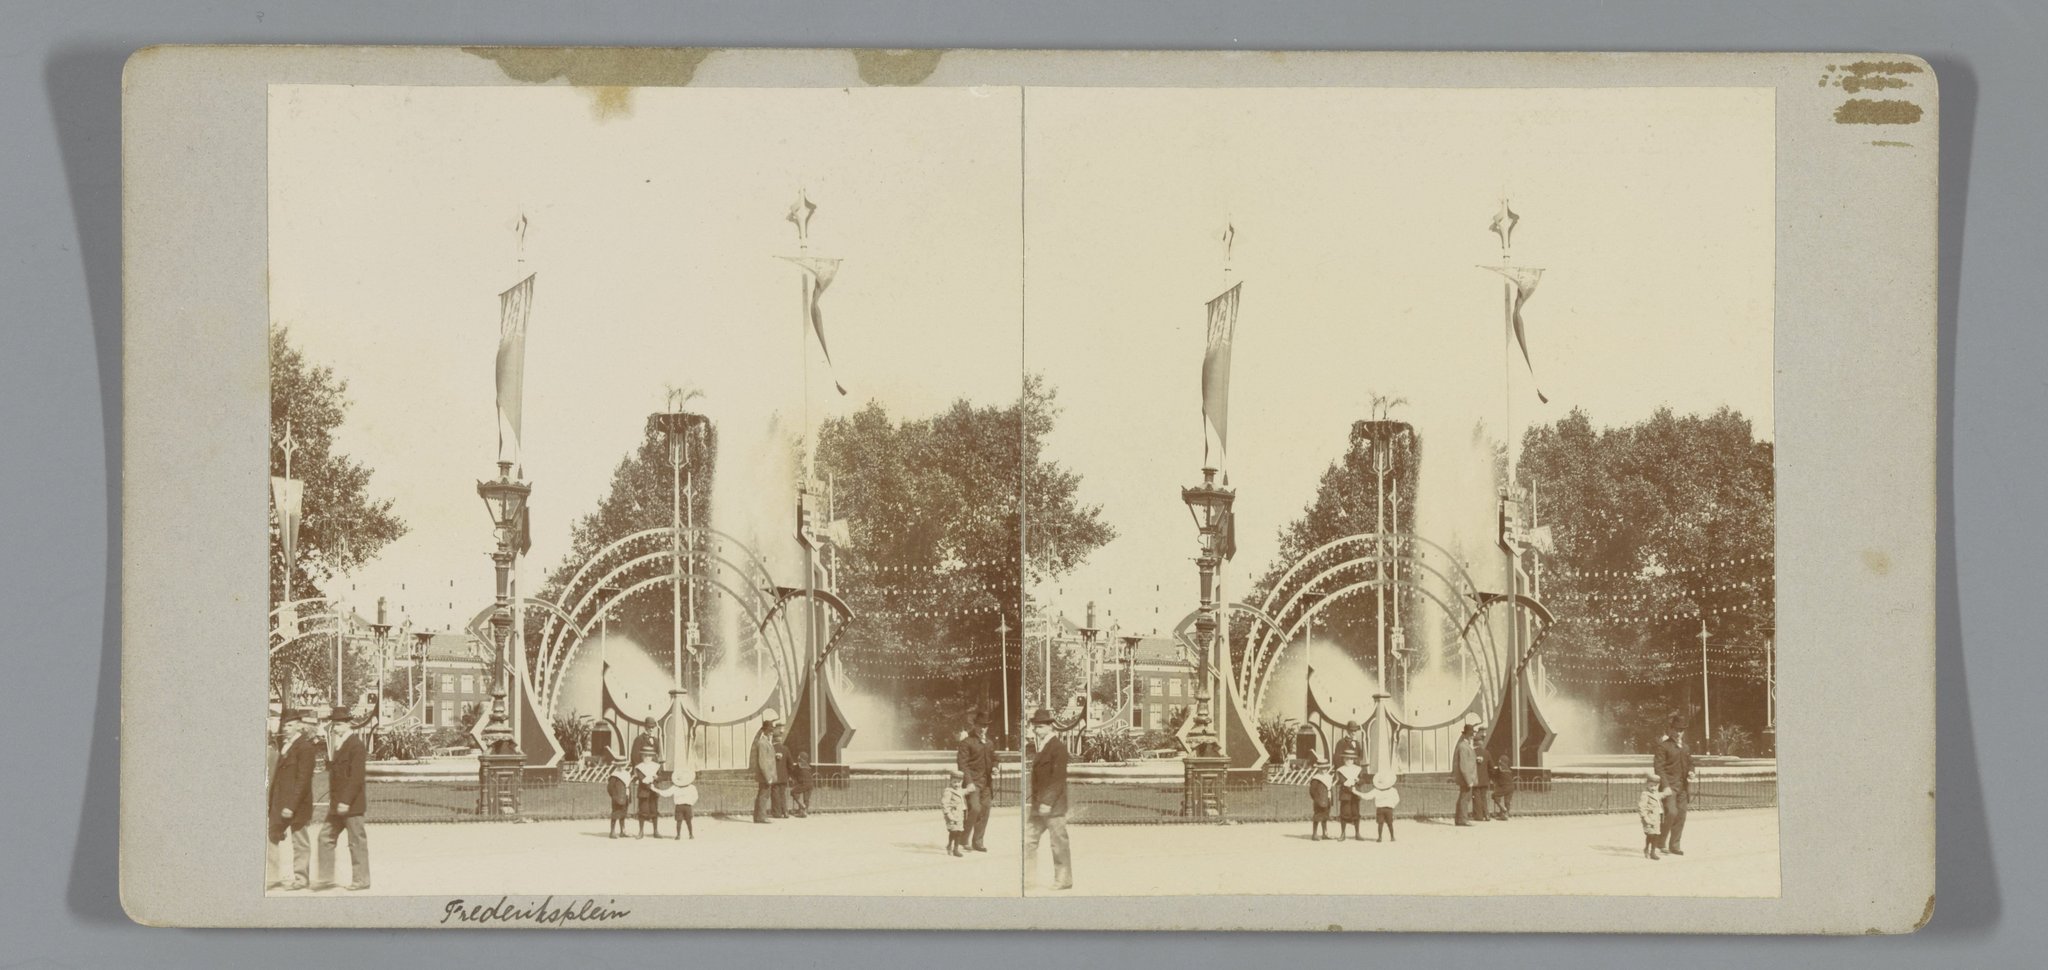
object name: stereograph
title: Fontein op het Frederiksplein, versierd ter gelegenheid van de inhuldiging van koningin Wilhelmina, Amsterdam, Nederland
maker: Anonymous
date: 1898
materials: paper, cardboard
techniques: gelatin silver print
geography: amsterdam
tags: the hague, print maker, wilhelmina of the netherlands, ornamental fountain